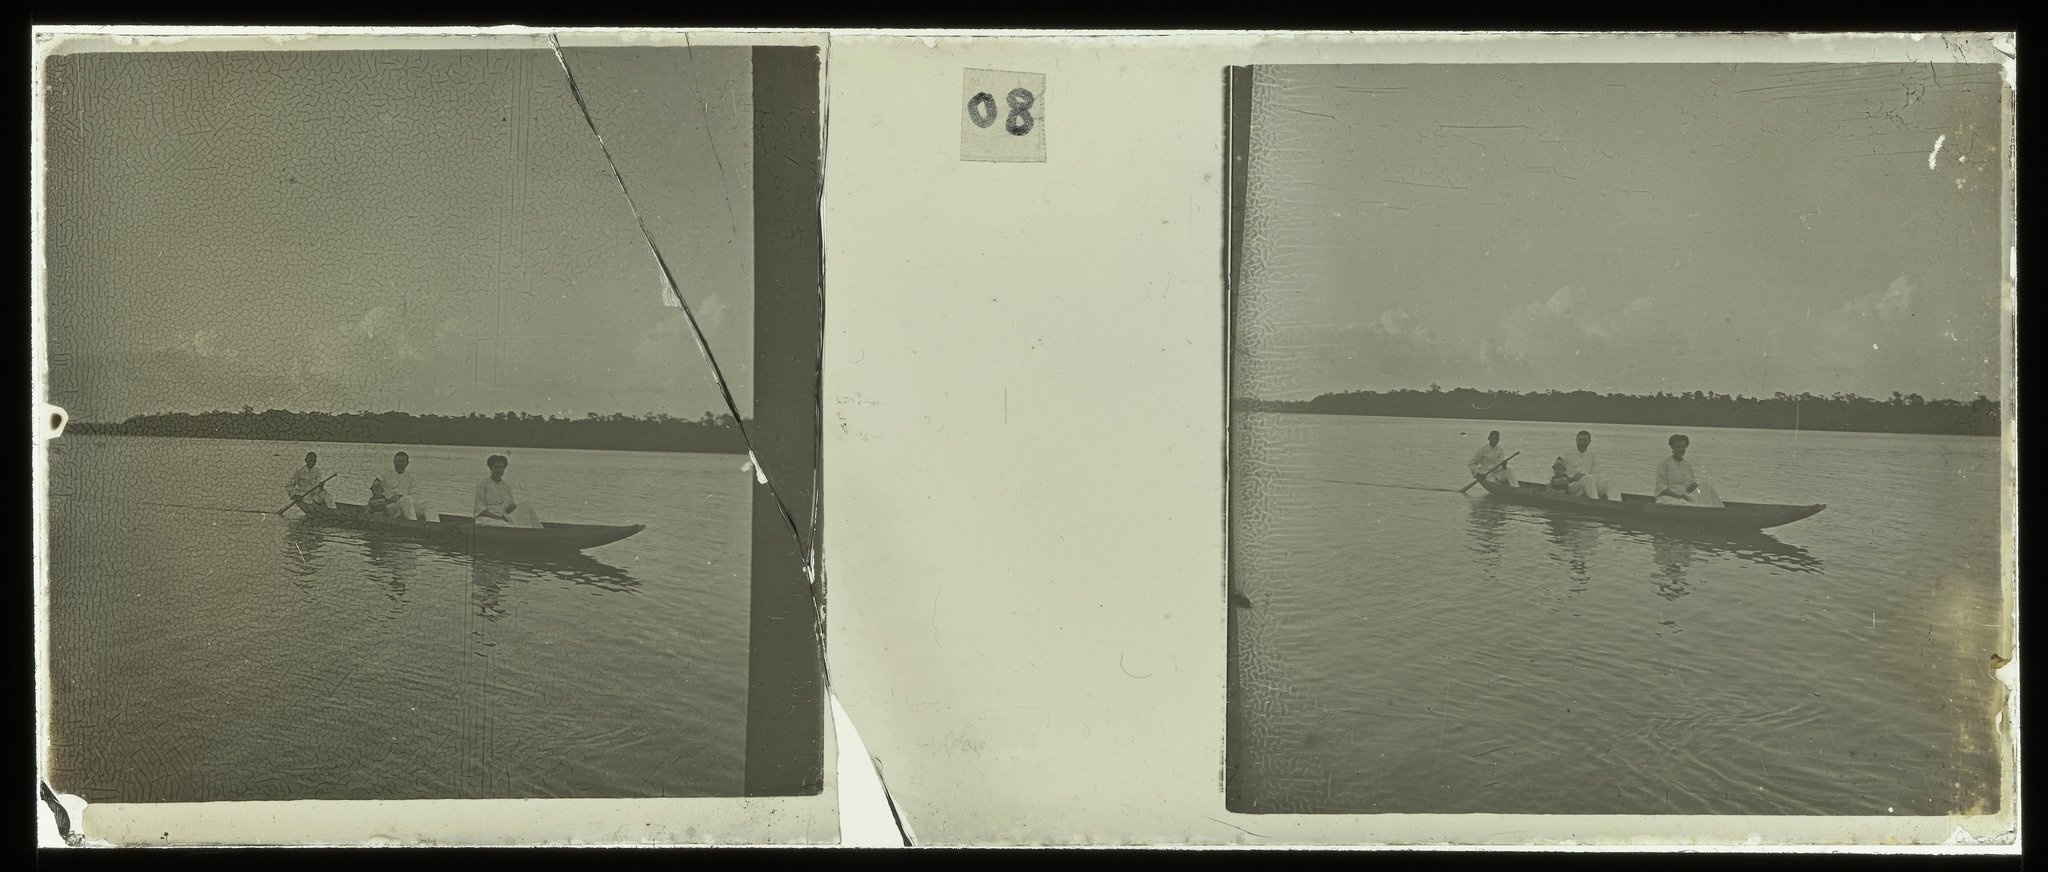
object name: stereograph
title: Familie Brouwers op de Surinamerivier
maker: Anonymous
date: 1913-1930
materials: glass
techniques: photography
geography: suriname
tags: amsterdam, theodoor brouwers, suriname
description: In de periode 1911-1932 woonde op plantage Accaribo in Suriname de familie Brouwers van wie de foto's afkomstig zijn. Rond 1910 vond Theodoor Brouwers werk op plantage Accaribo. In 1929 werd hij eigenaar van de plantage. Op Accaribo werden in zijn tijd bananen geproduceerd en wat koffie.